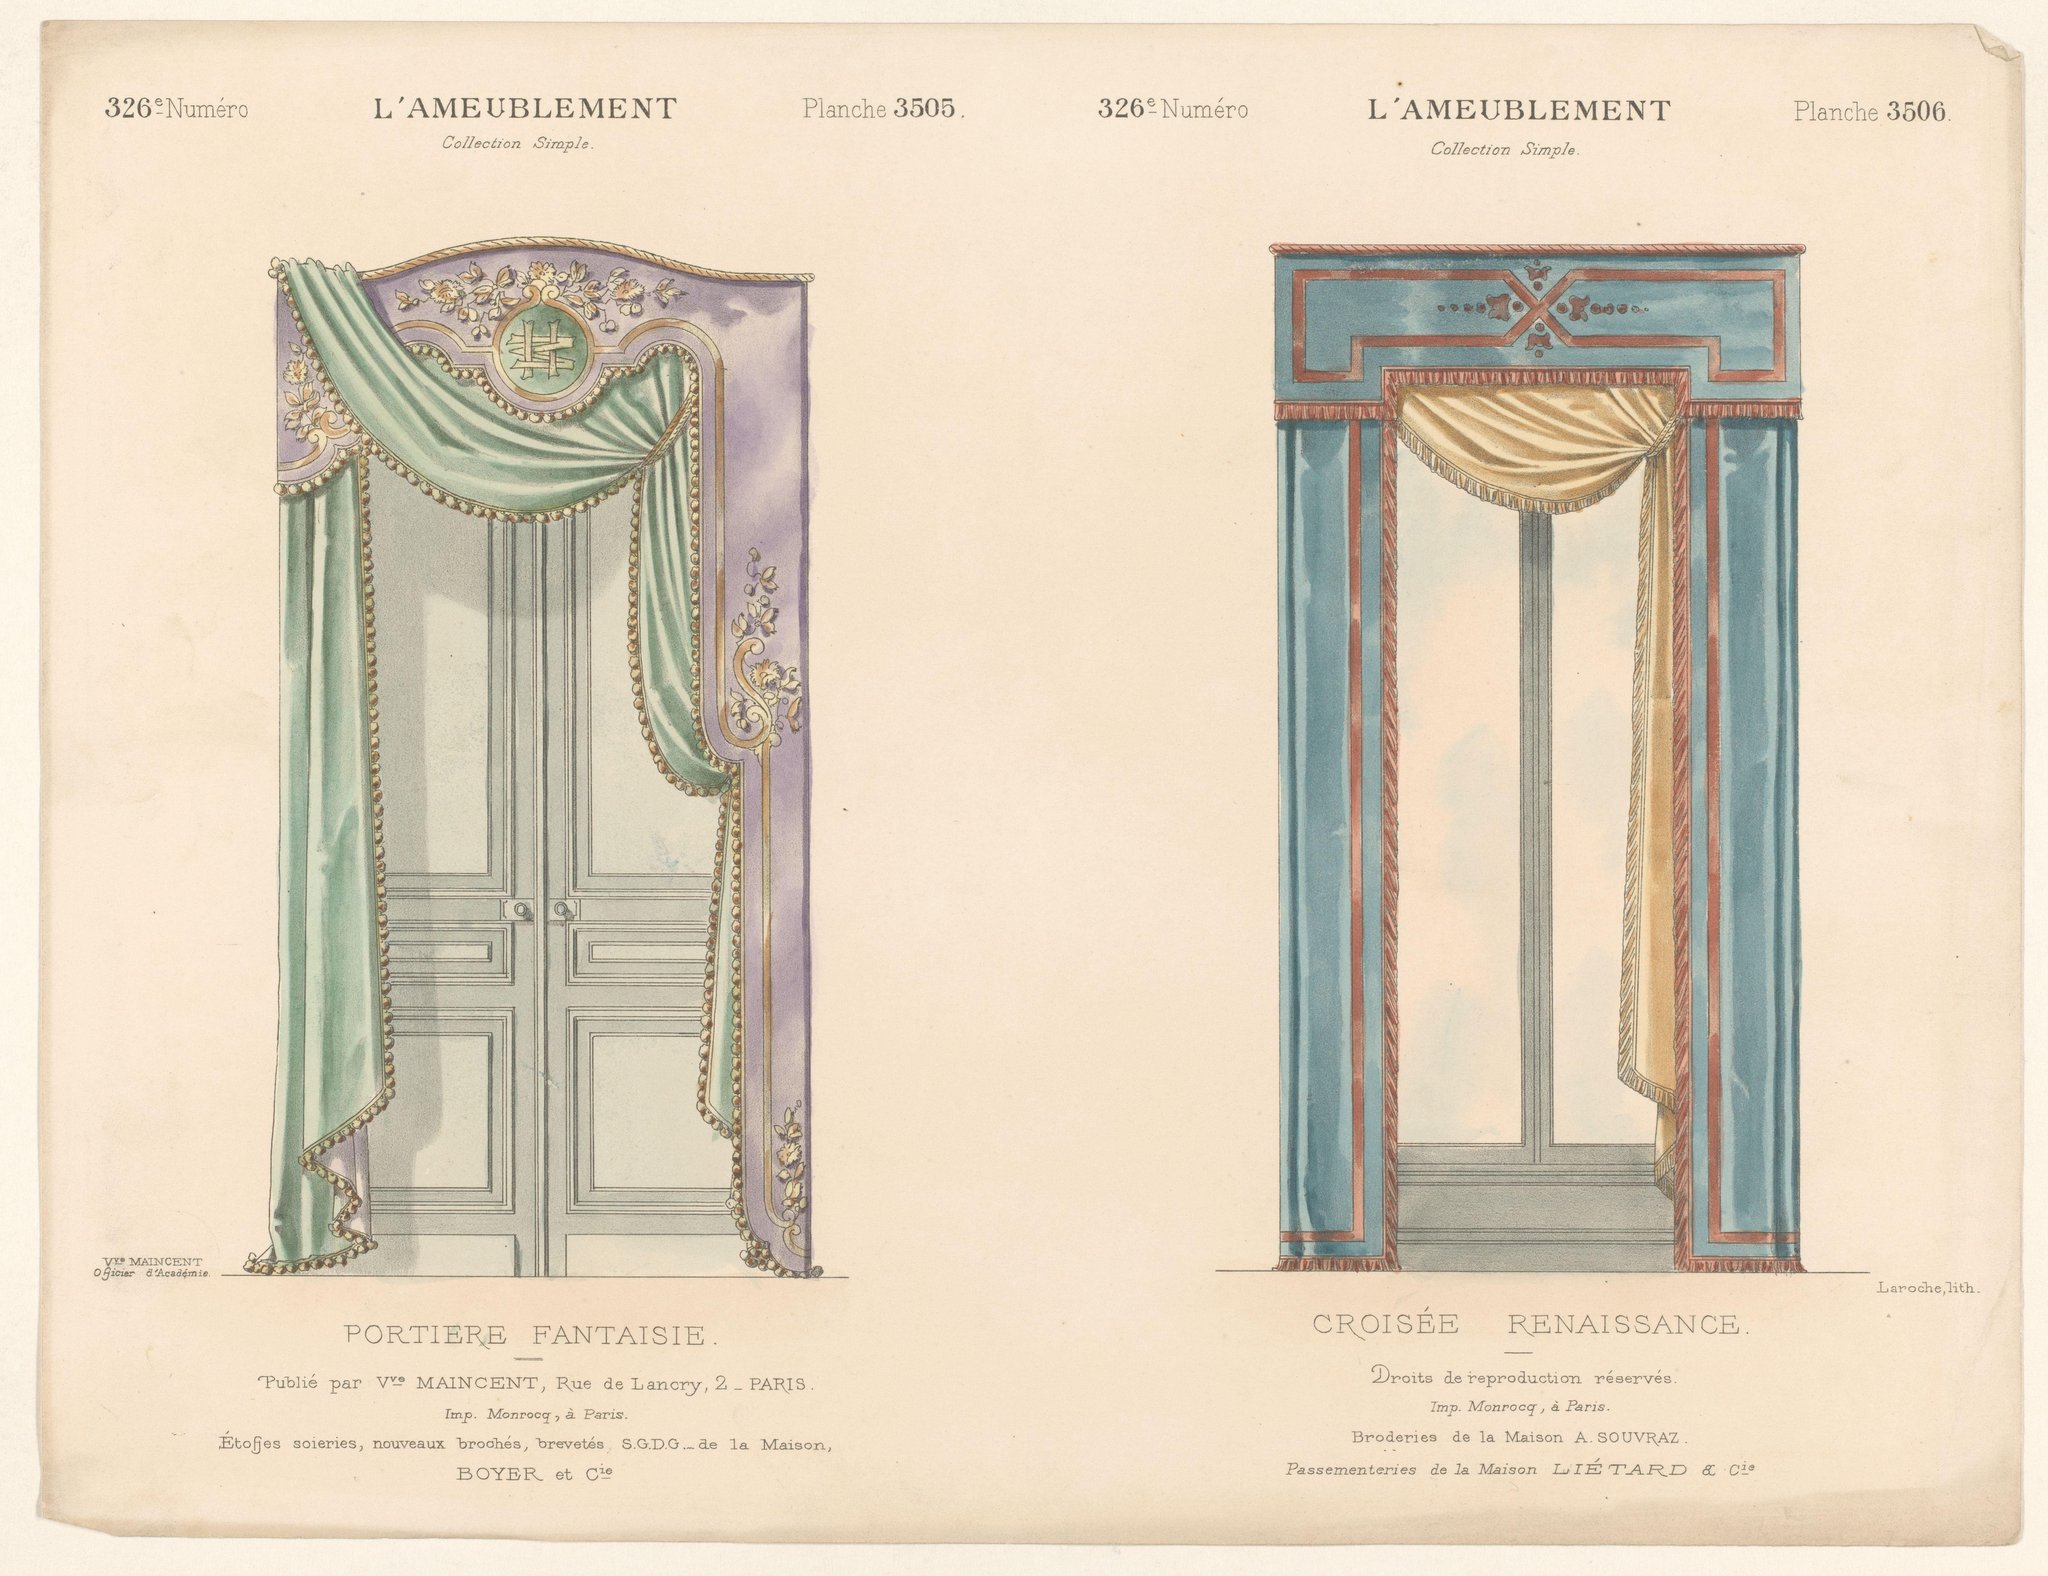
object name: print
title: Portière fantaisie / Croisée renaissance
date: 1895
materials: paper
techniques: hand coloring, lithograph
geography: paris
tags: window, door, hangings and drapery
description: Een deur en een renaissance venster met gedrapeerde gordijnen. Prent uit 326e Livraison.